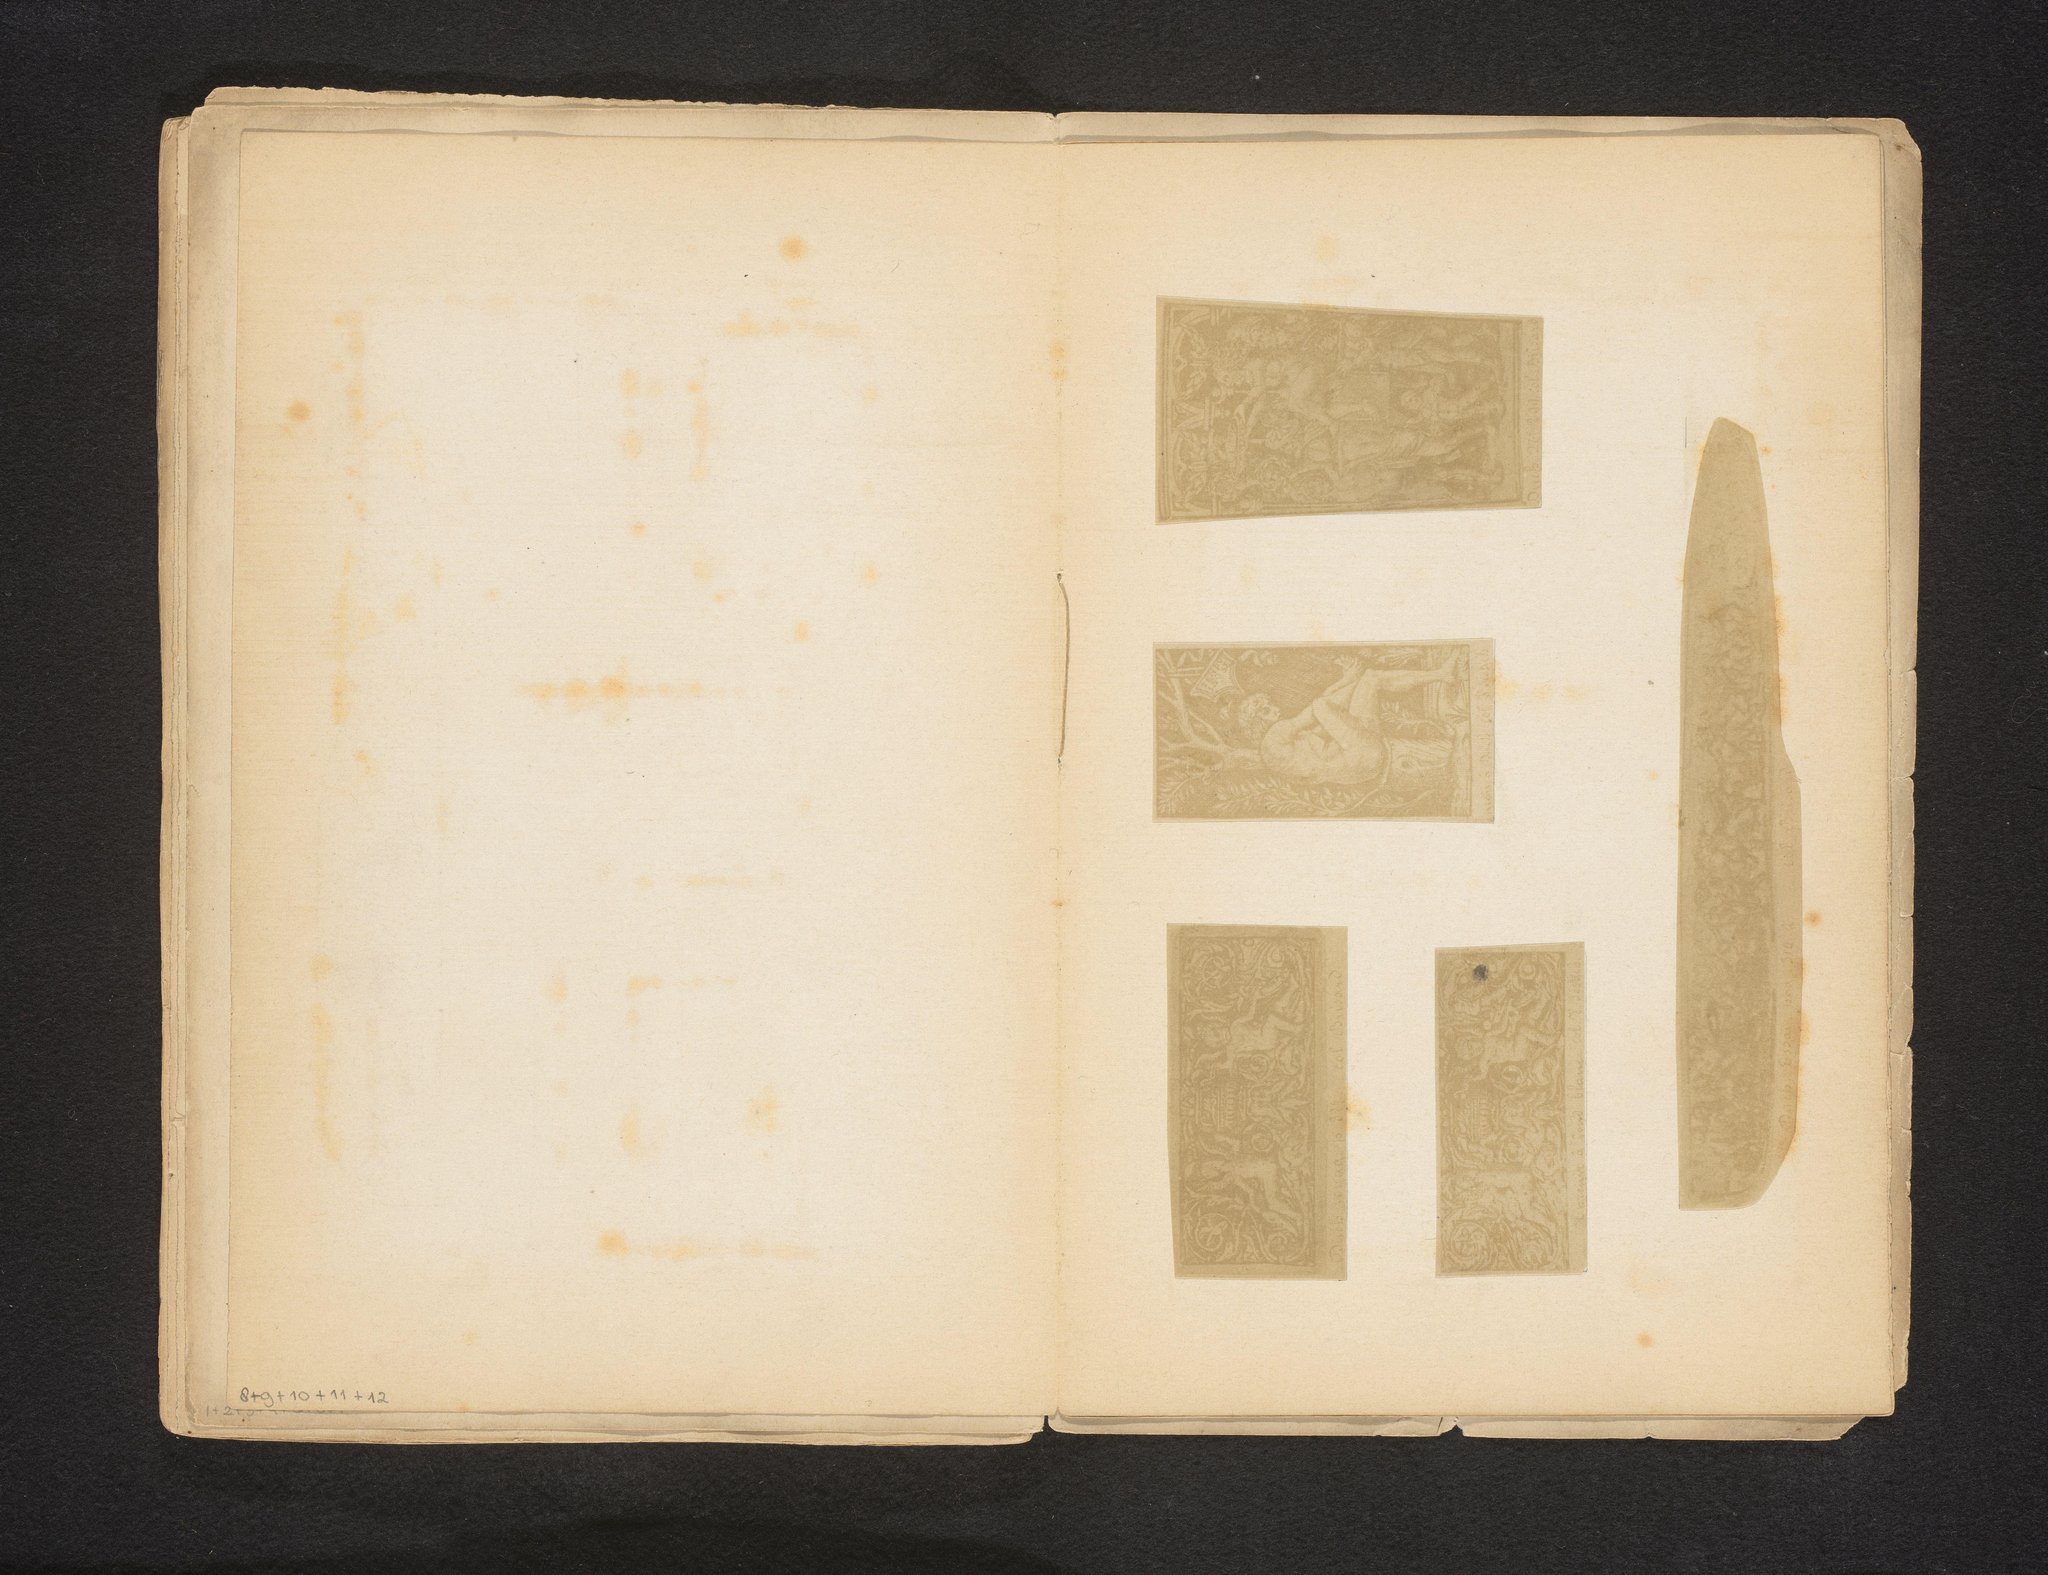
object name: photograph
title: Fotoreproductie van een prent van de Spinario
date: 1852-1857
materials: photographic support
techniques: salted paper print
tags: 'spinario', child pulling a thorn out of its foot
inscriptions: inscription: ‘[...]nion à Duch. col. V. Sestich’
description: Foto op blad met vijf foto's op vijfde ongenummerde pagina na pagina 60.